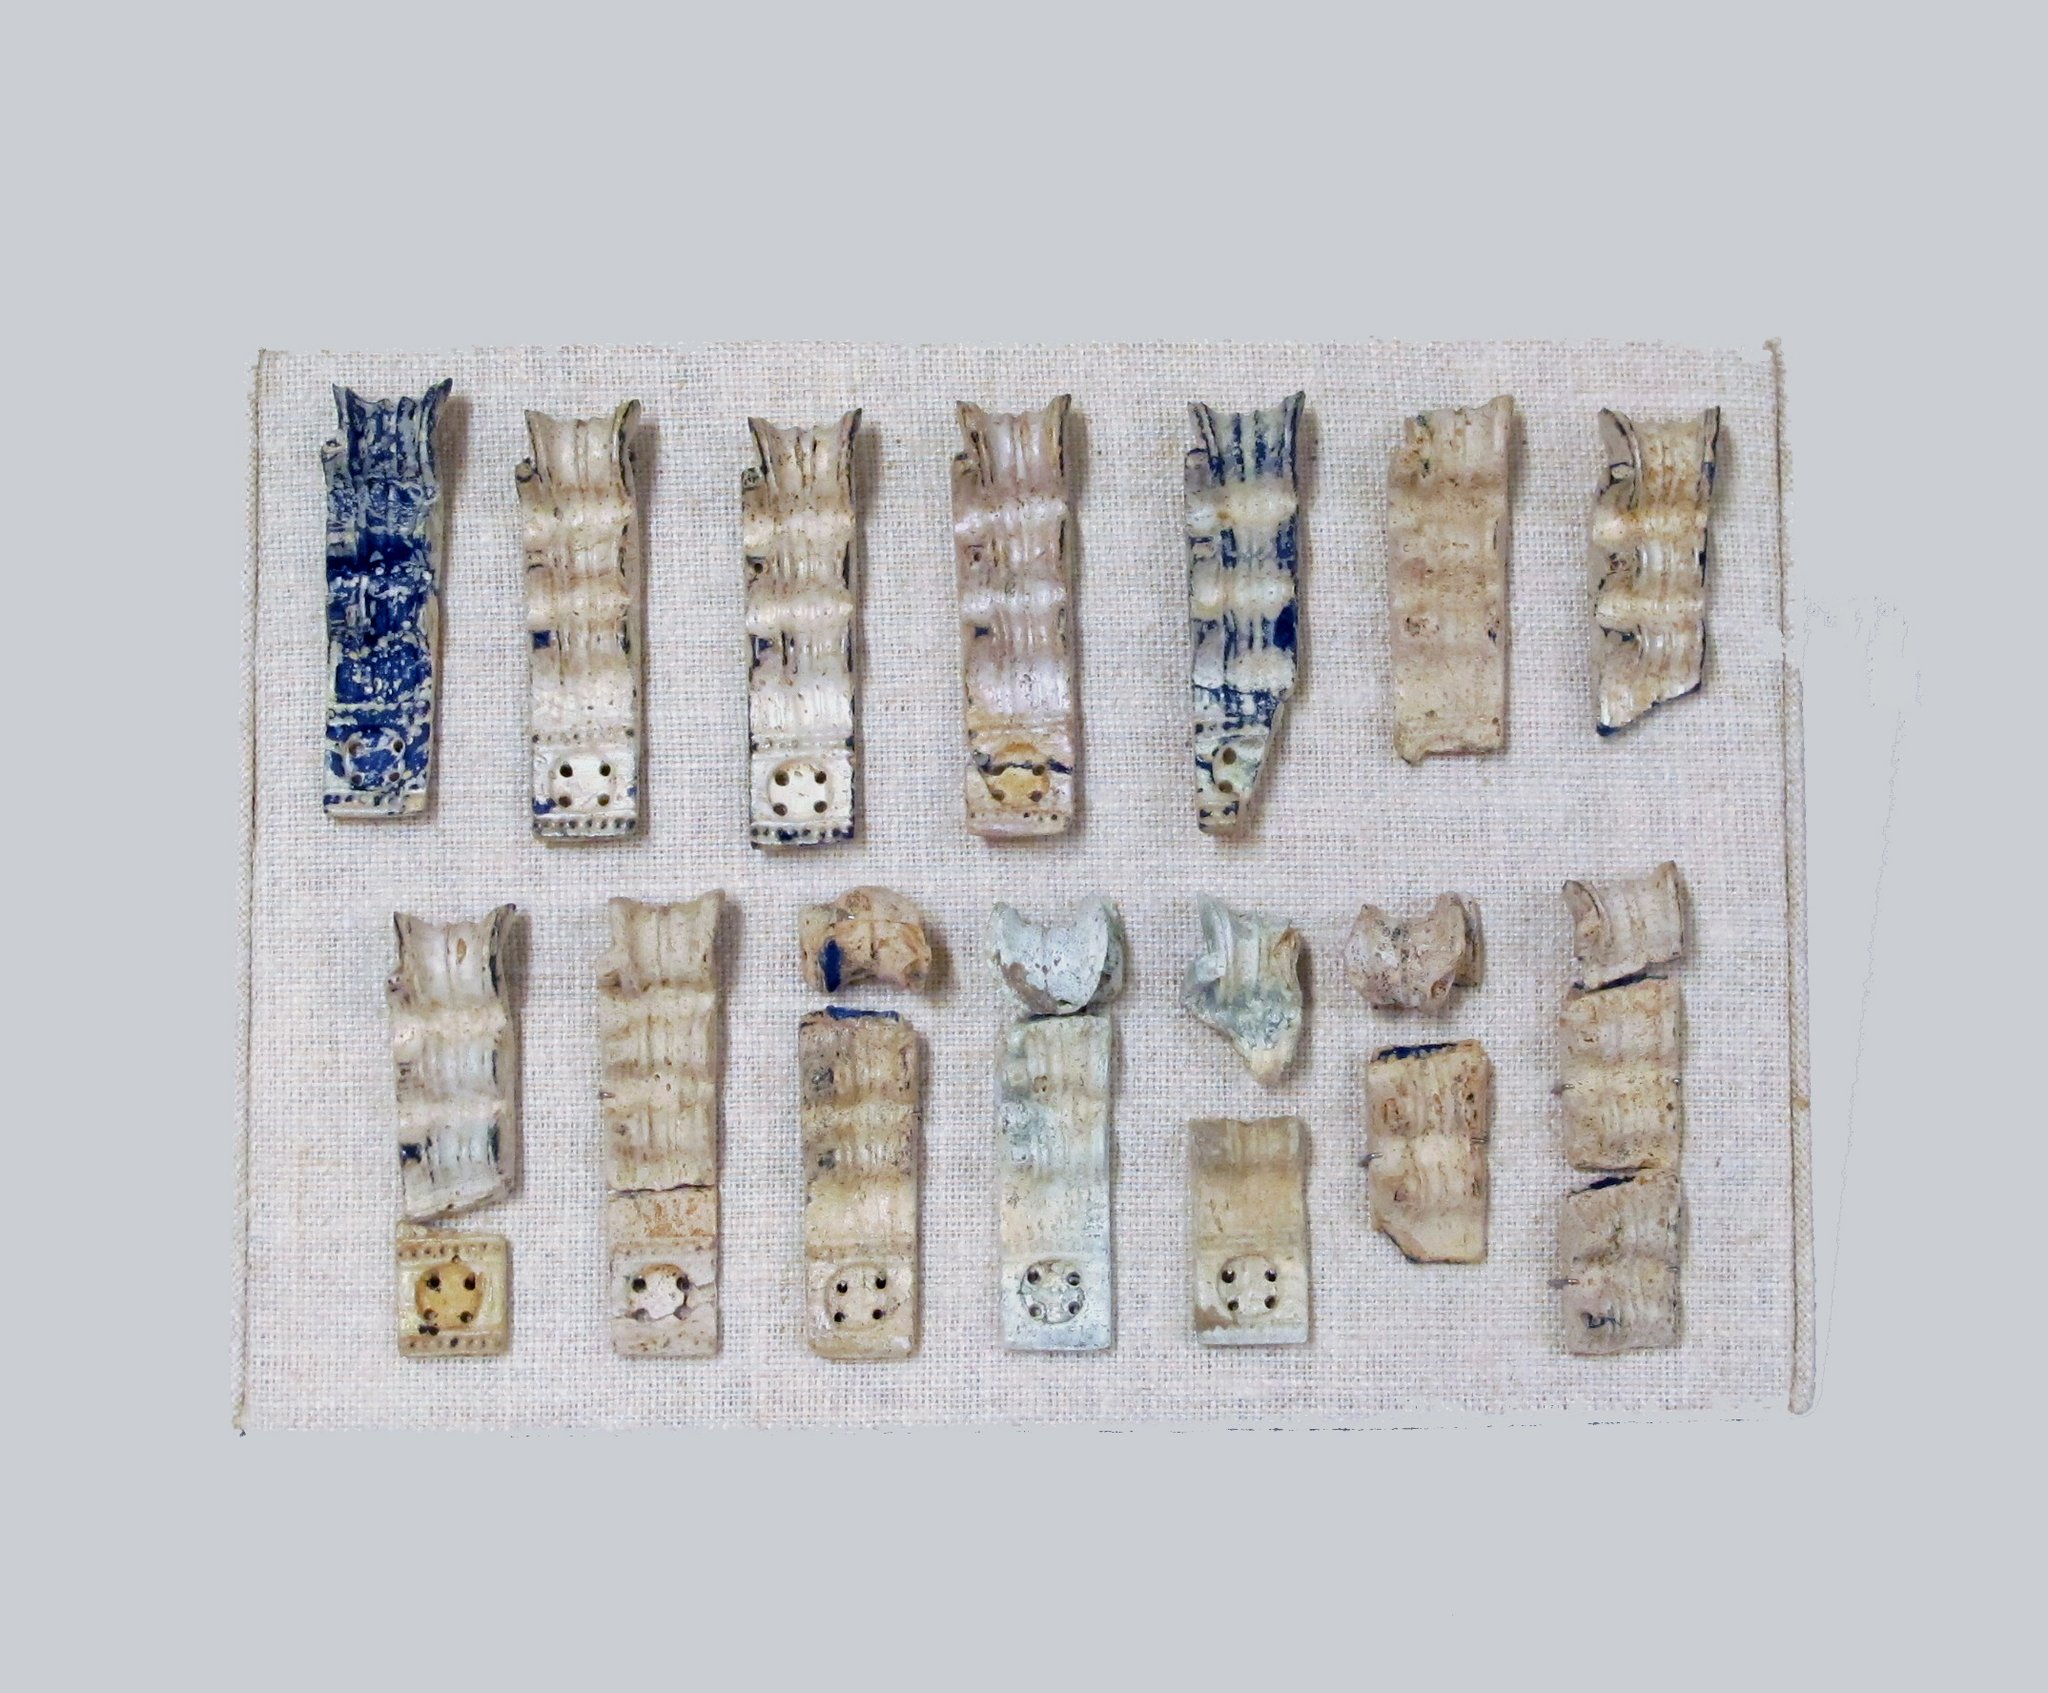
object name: ornament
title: Glass ornaments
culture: aegean, helladic or mycenaean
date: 1370-1200 BCE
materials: glass